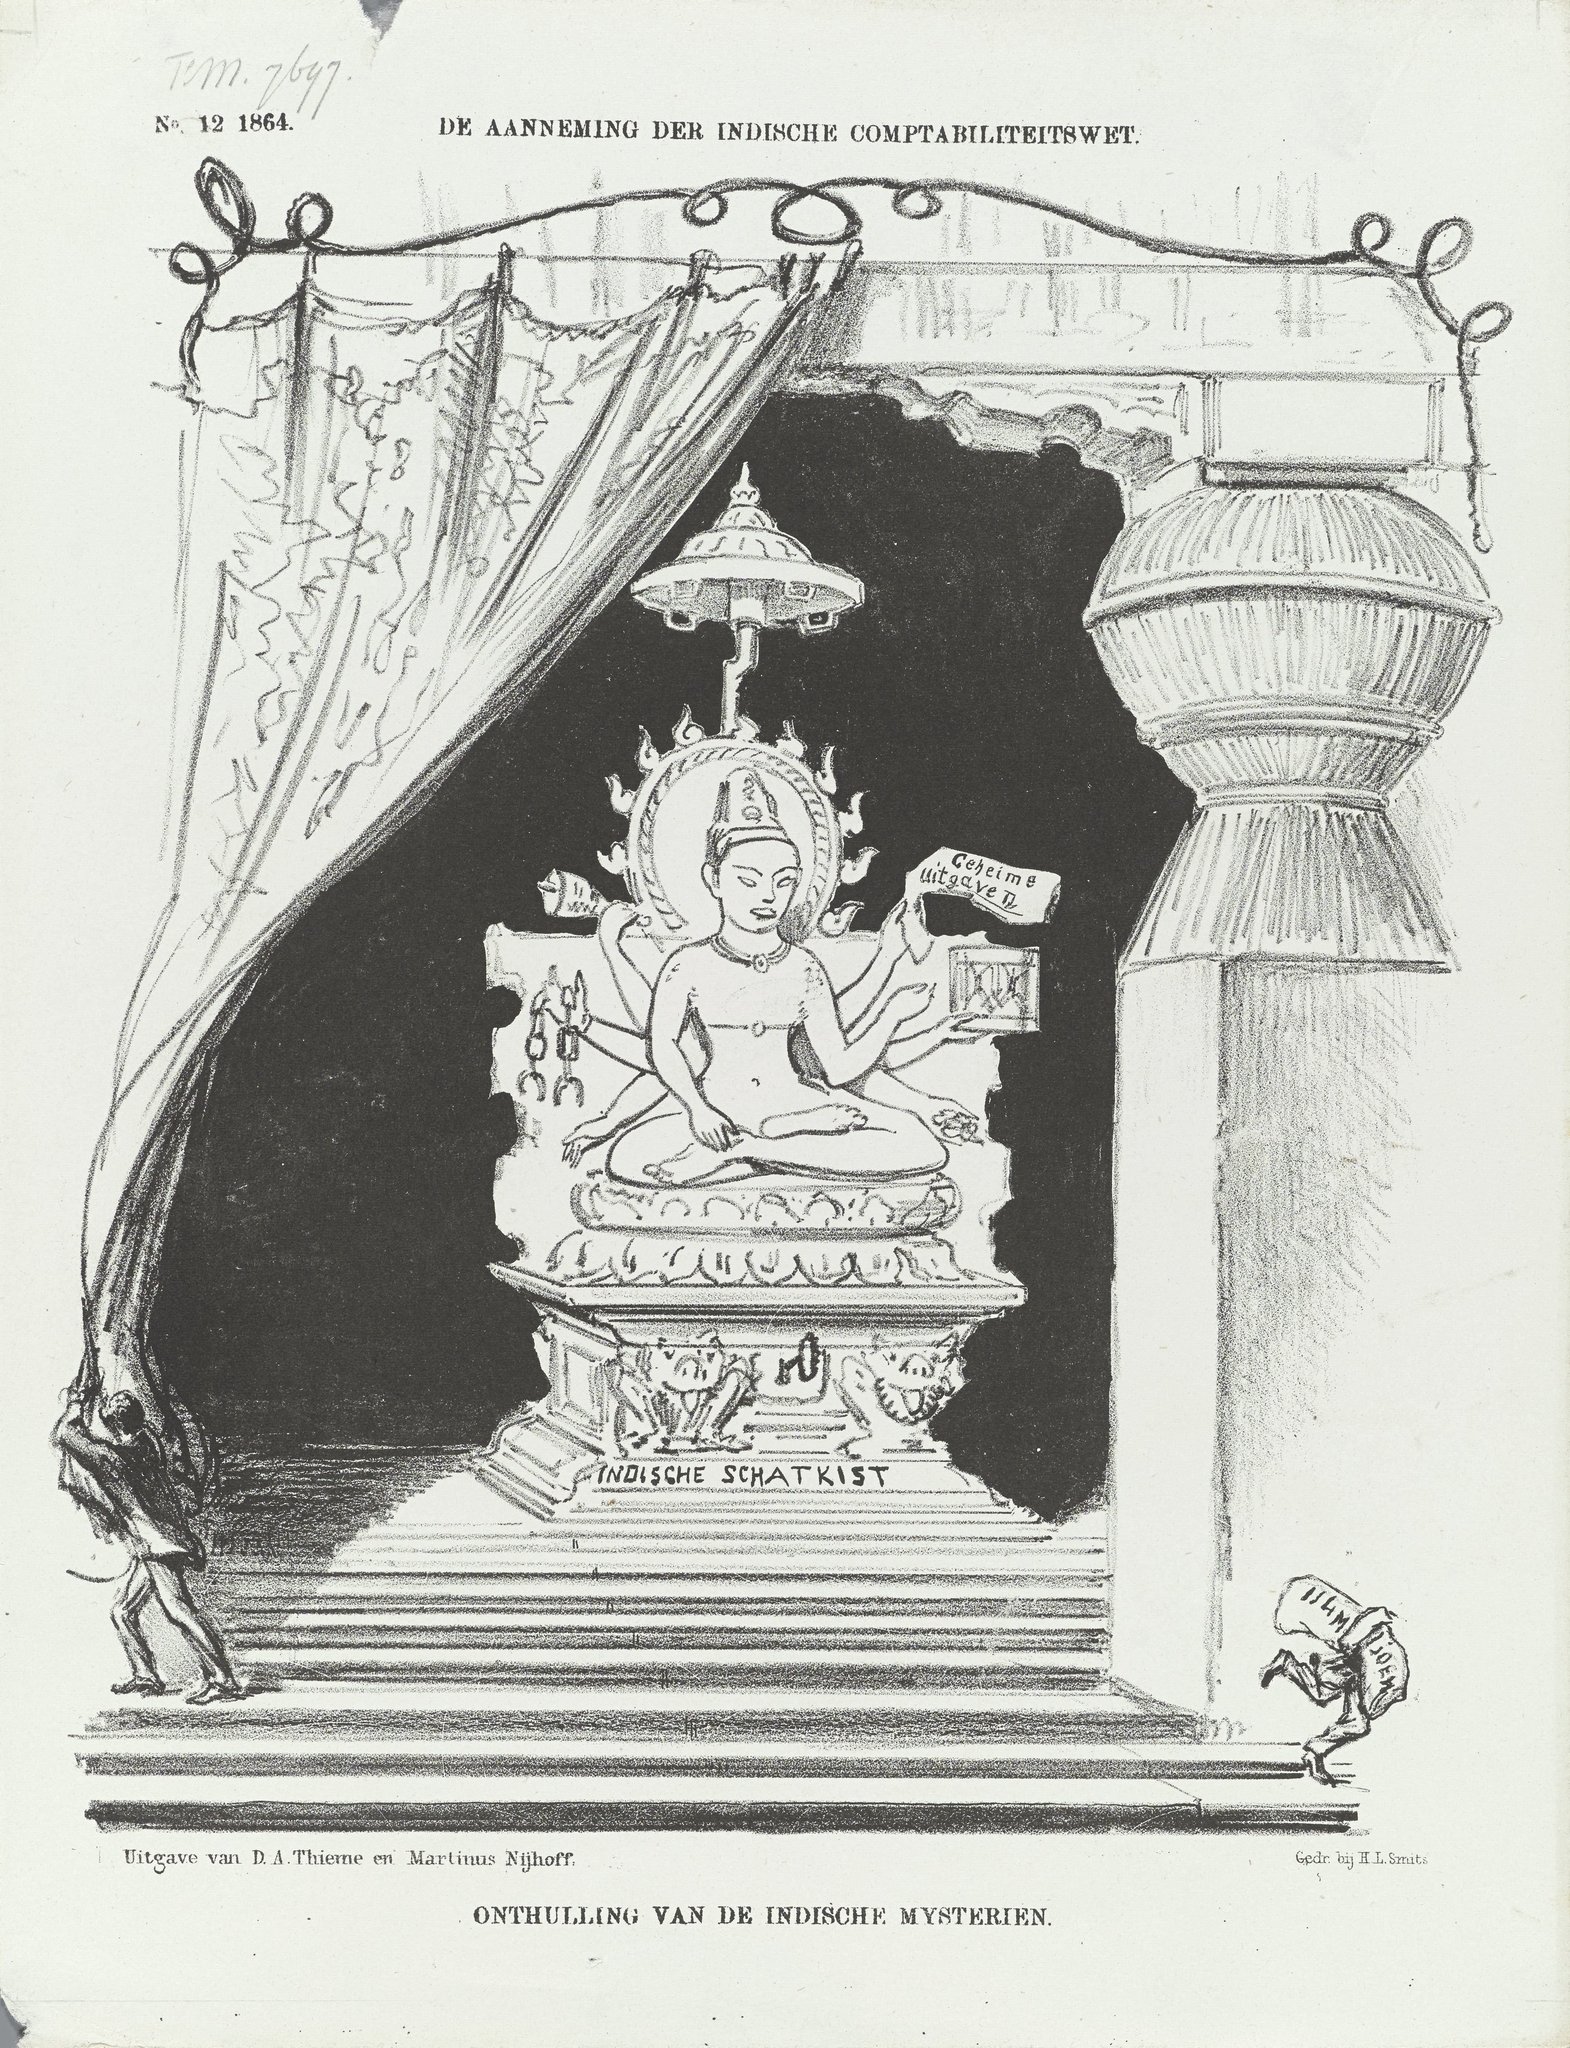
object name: print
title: Spotprent op de aanneming van de Indische compatibiliteitswet, 1864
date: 1864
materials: paper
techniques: lithograph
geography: arnhem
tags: statues, paintings, etc. ~ objects of worship (hinduism, buddhism, jainism), dutch east indies, the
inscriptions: collector's mark: Lugt 2228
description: Spotprent op de aanneming van de Indische compatibiliteitswet waarbij de Indische begroting bij wet wordt vastgesteld. Een gordijn wordt opzij geschoven waardoor een groot beeld van een boeddhistische godheid zichtbaar wordt, zittend op de Indische schatkist. Plaat verschenen bij het weekblad De Nederlandsche Spectator, nr. 12, 19 maart 1864.